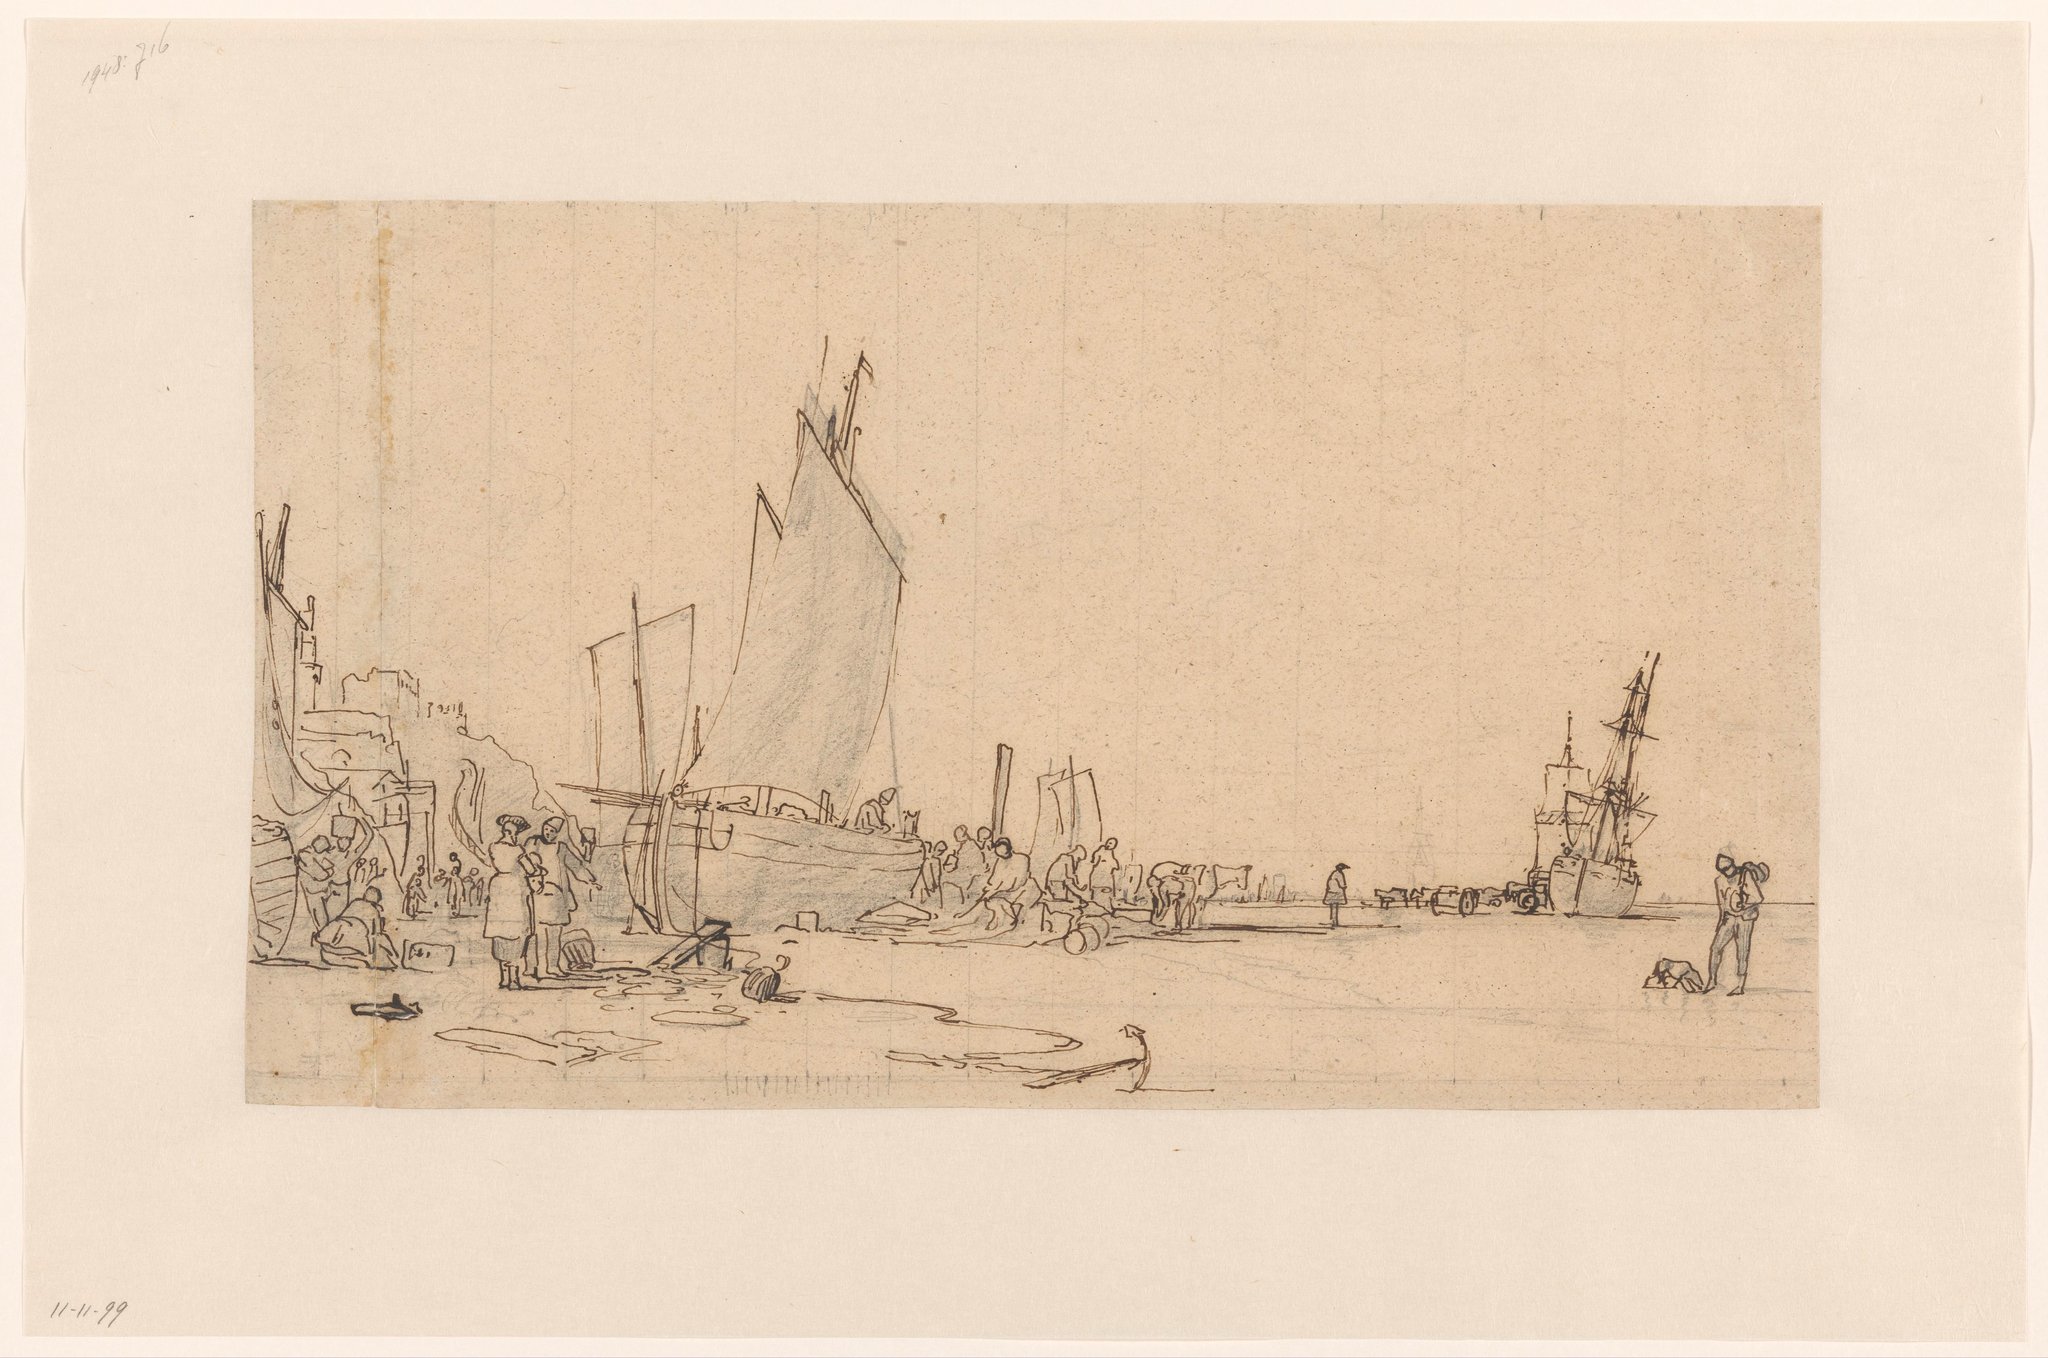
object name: drawing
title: Schepen op het strand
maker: johannes christiaan schotel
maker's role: draughtsman, painter, print maker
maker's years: 1787-1838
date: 1797-1838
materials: ink, paper, pencil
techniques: pen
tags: sailing-ship, sailing-boat, beach